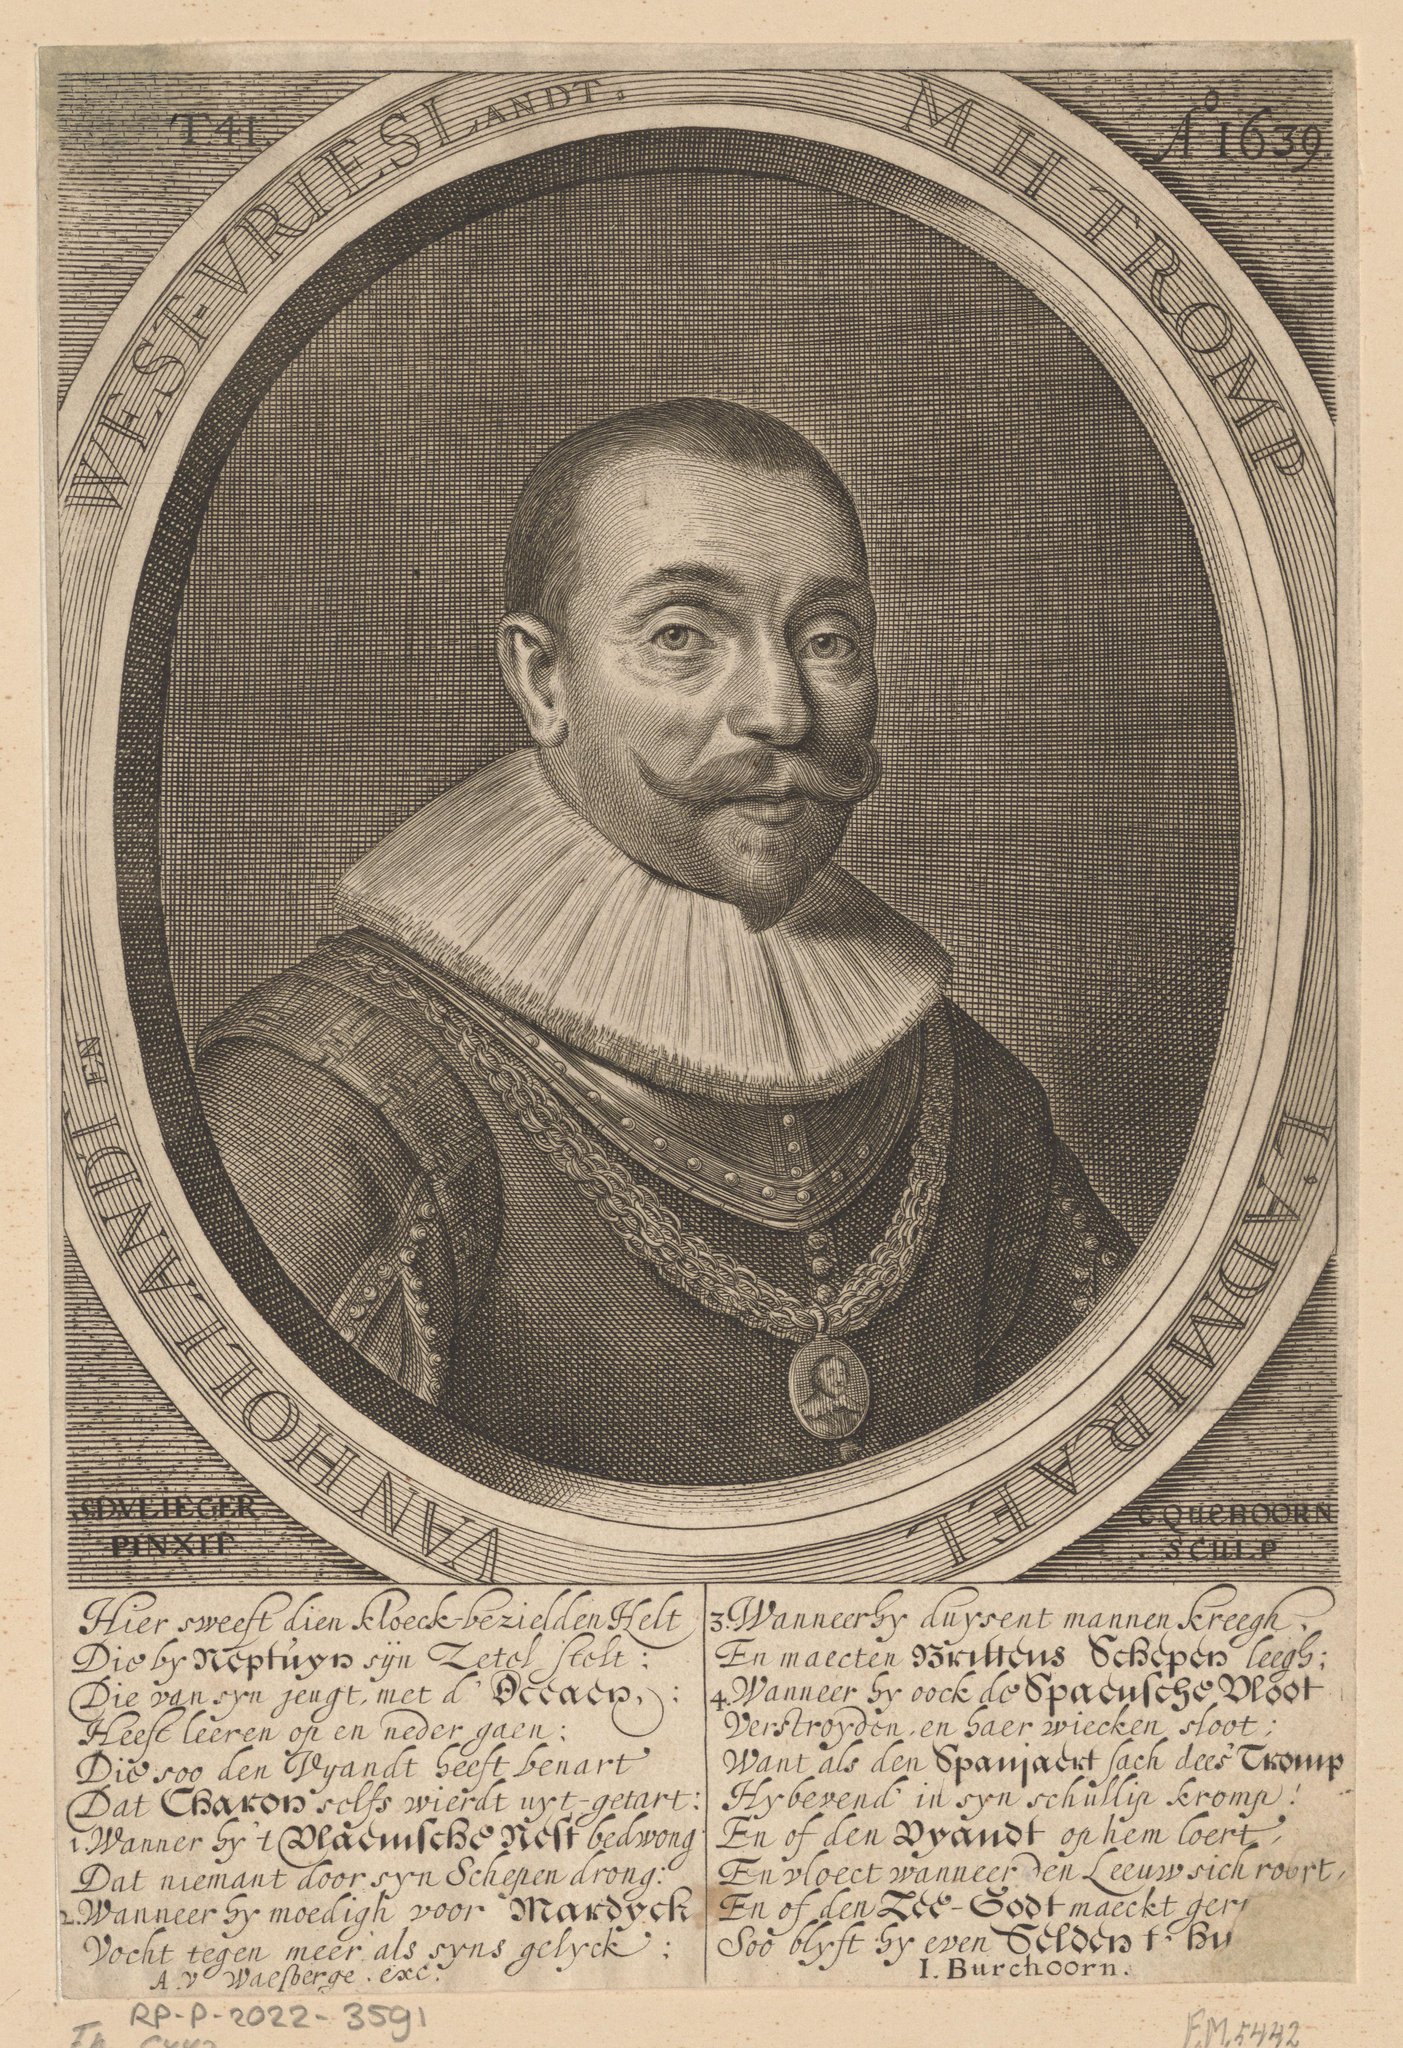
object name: print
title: Portret van Maarten Harpertszoon Tromp op 41-jarige leeftijd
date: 1639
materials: paper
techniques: engraving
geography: northern netherlands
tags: brielle, maarten harpertszoon tromp, historical persons, medals and other marks of military honour, commander-in-chief, admiral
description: Met twintigregelig onderschrift in het Nederlands.